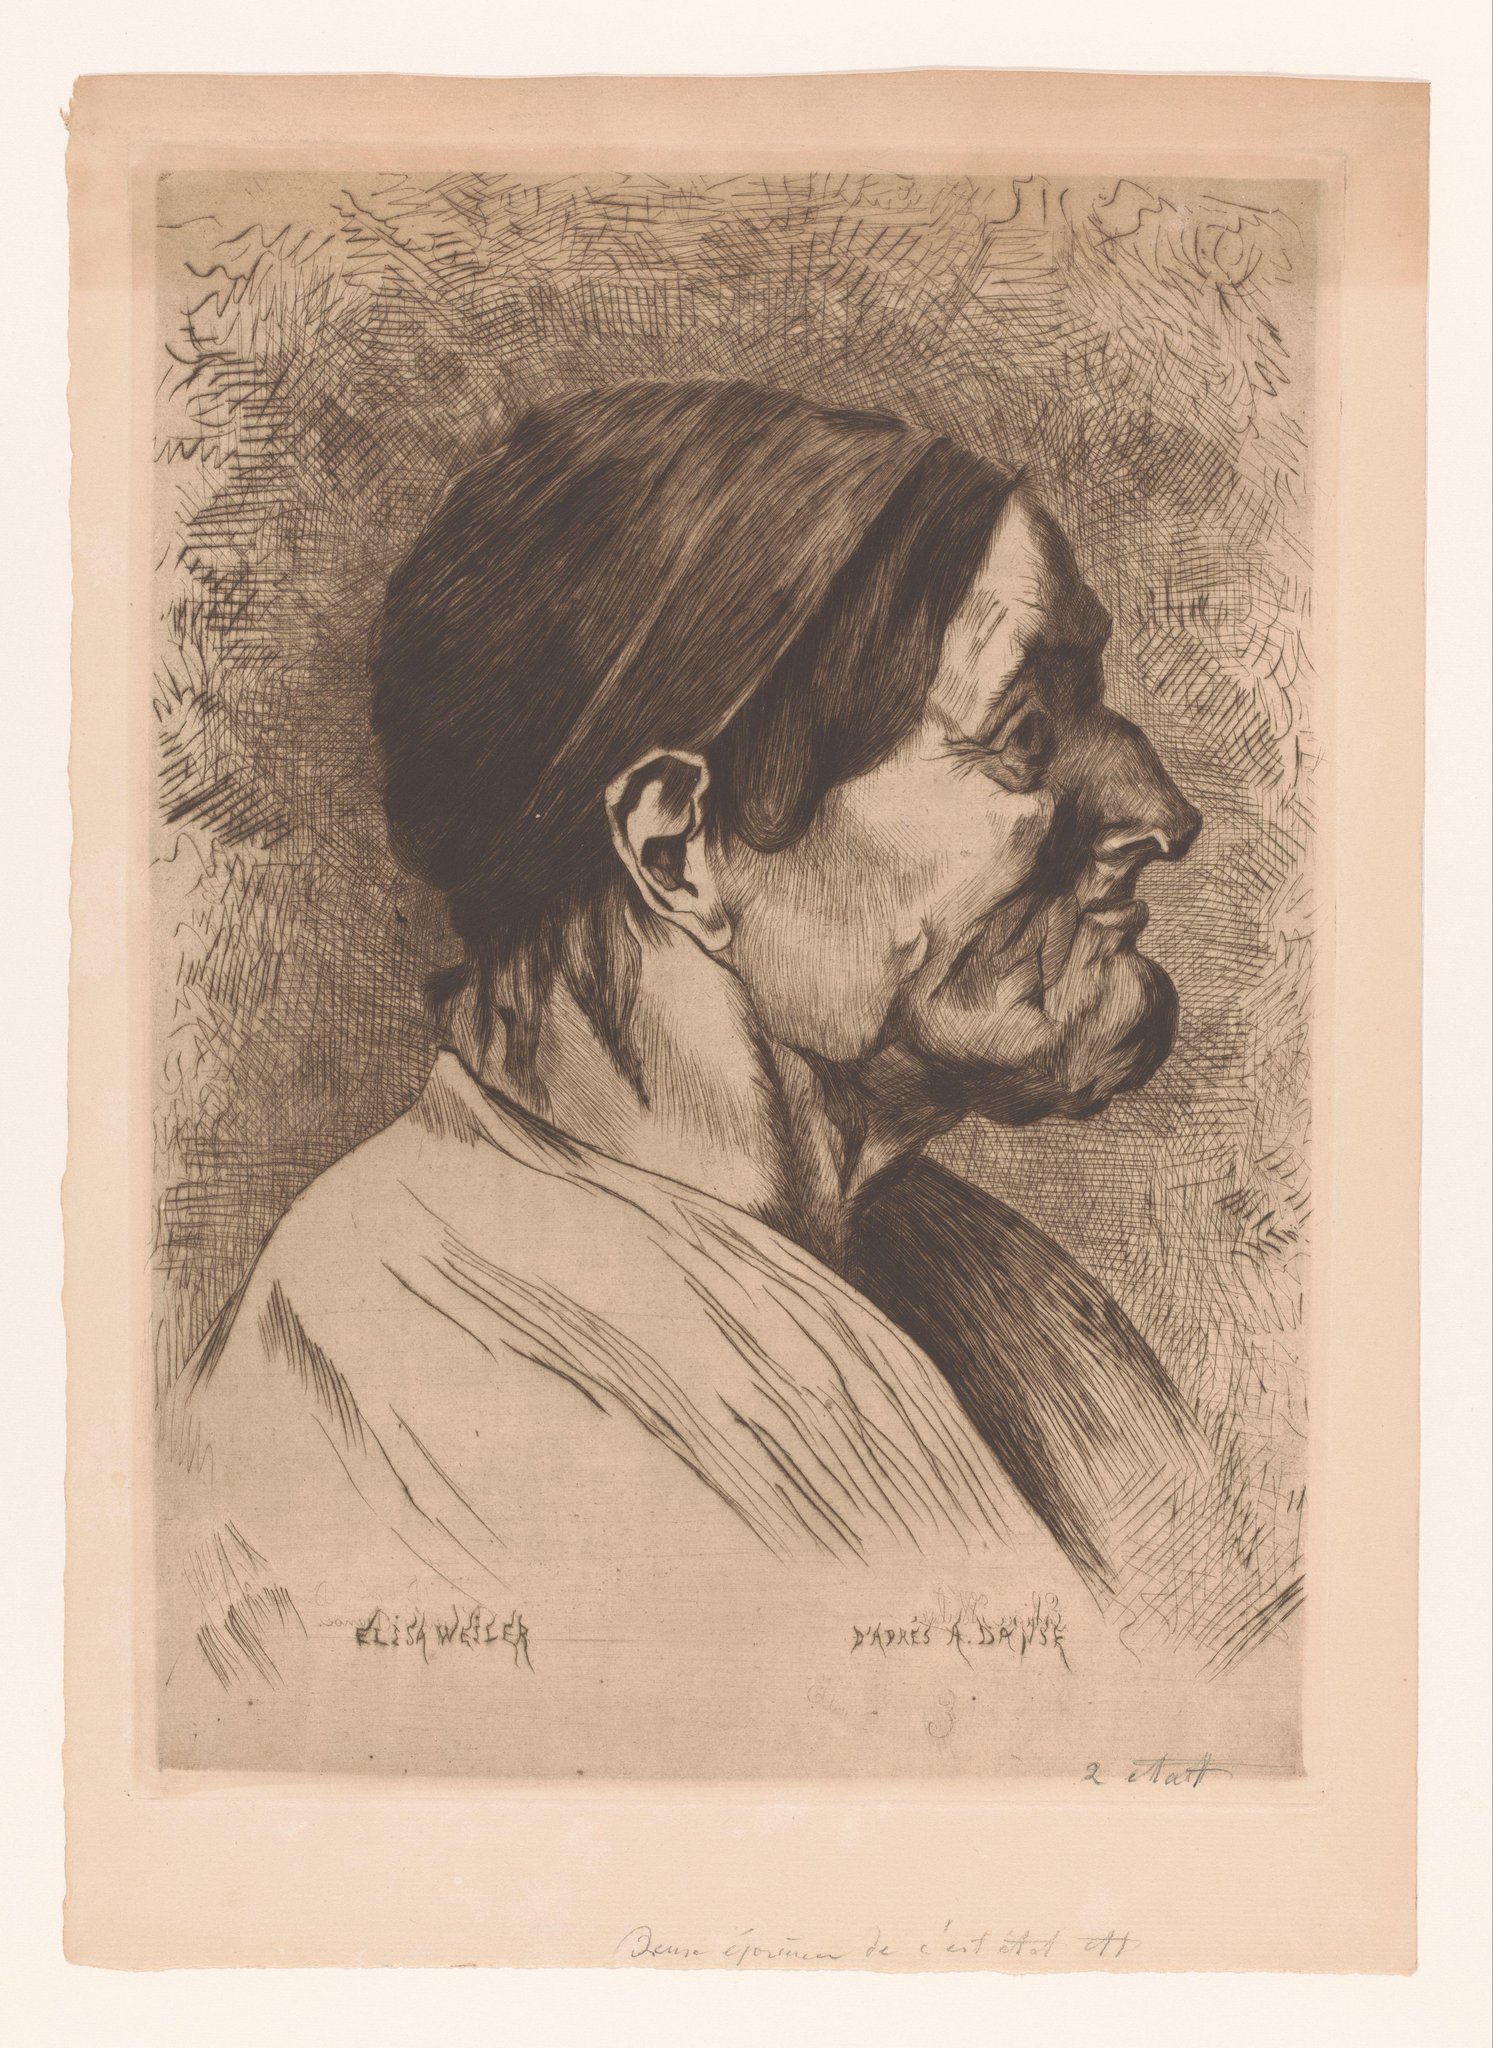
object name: print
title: Hoofd van een oude vrouw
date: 1875-1913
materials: paper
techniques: drypoint, etching, intaglio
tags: old woman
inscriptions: collector's mark: Lugt 2228, collector's mark: ‘2 etat; Deux épreuves de c'est état AD’